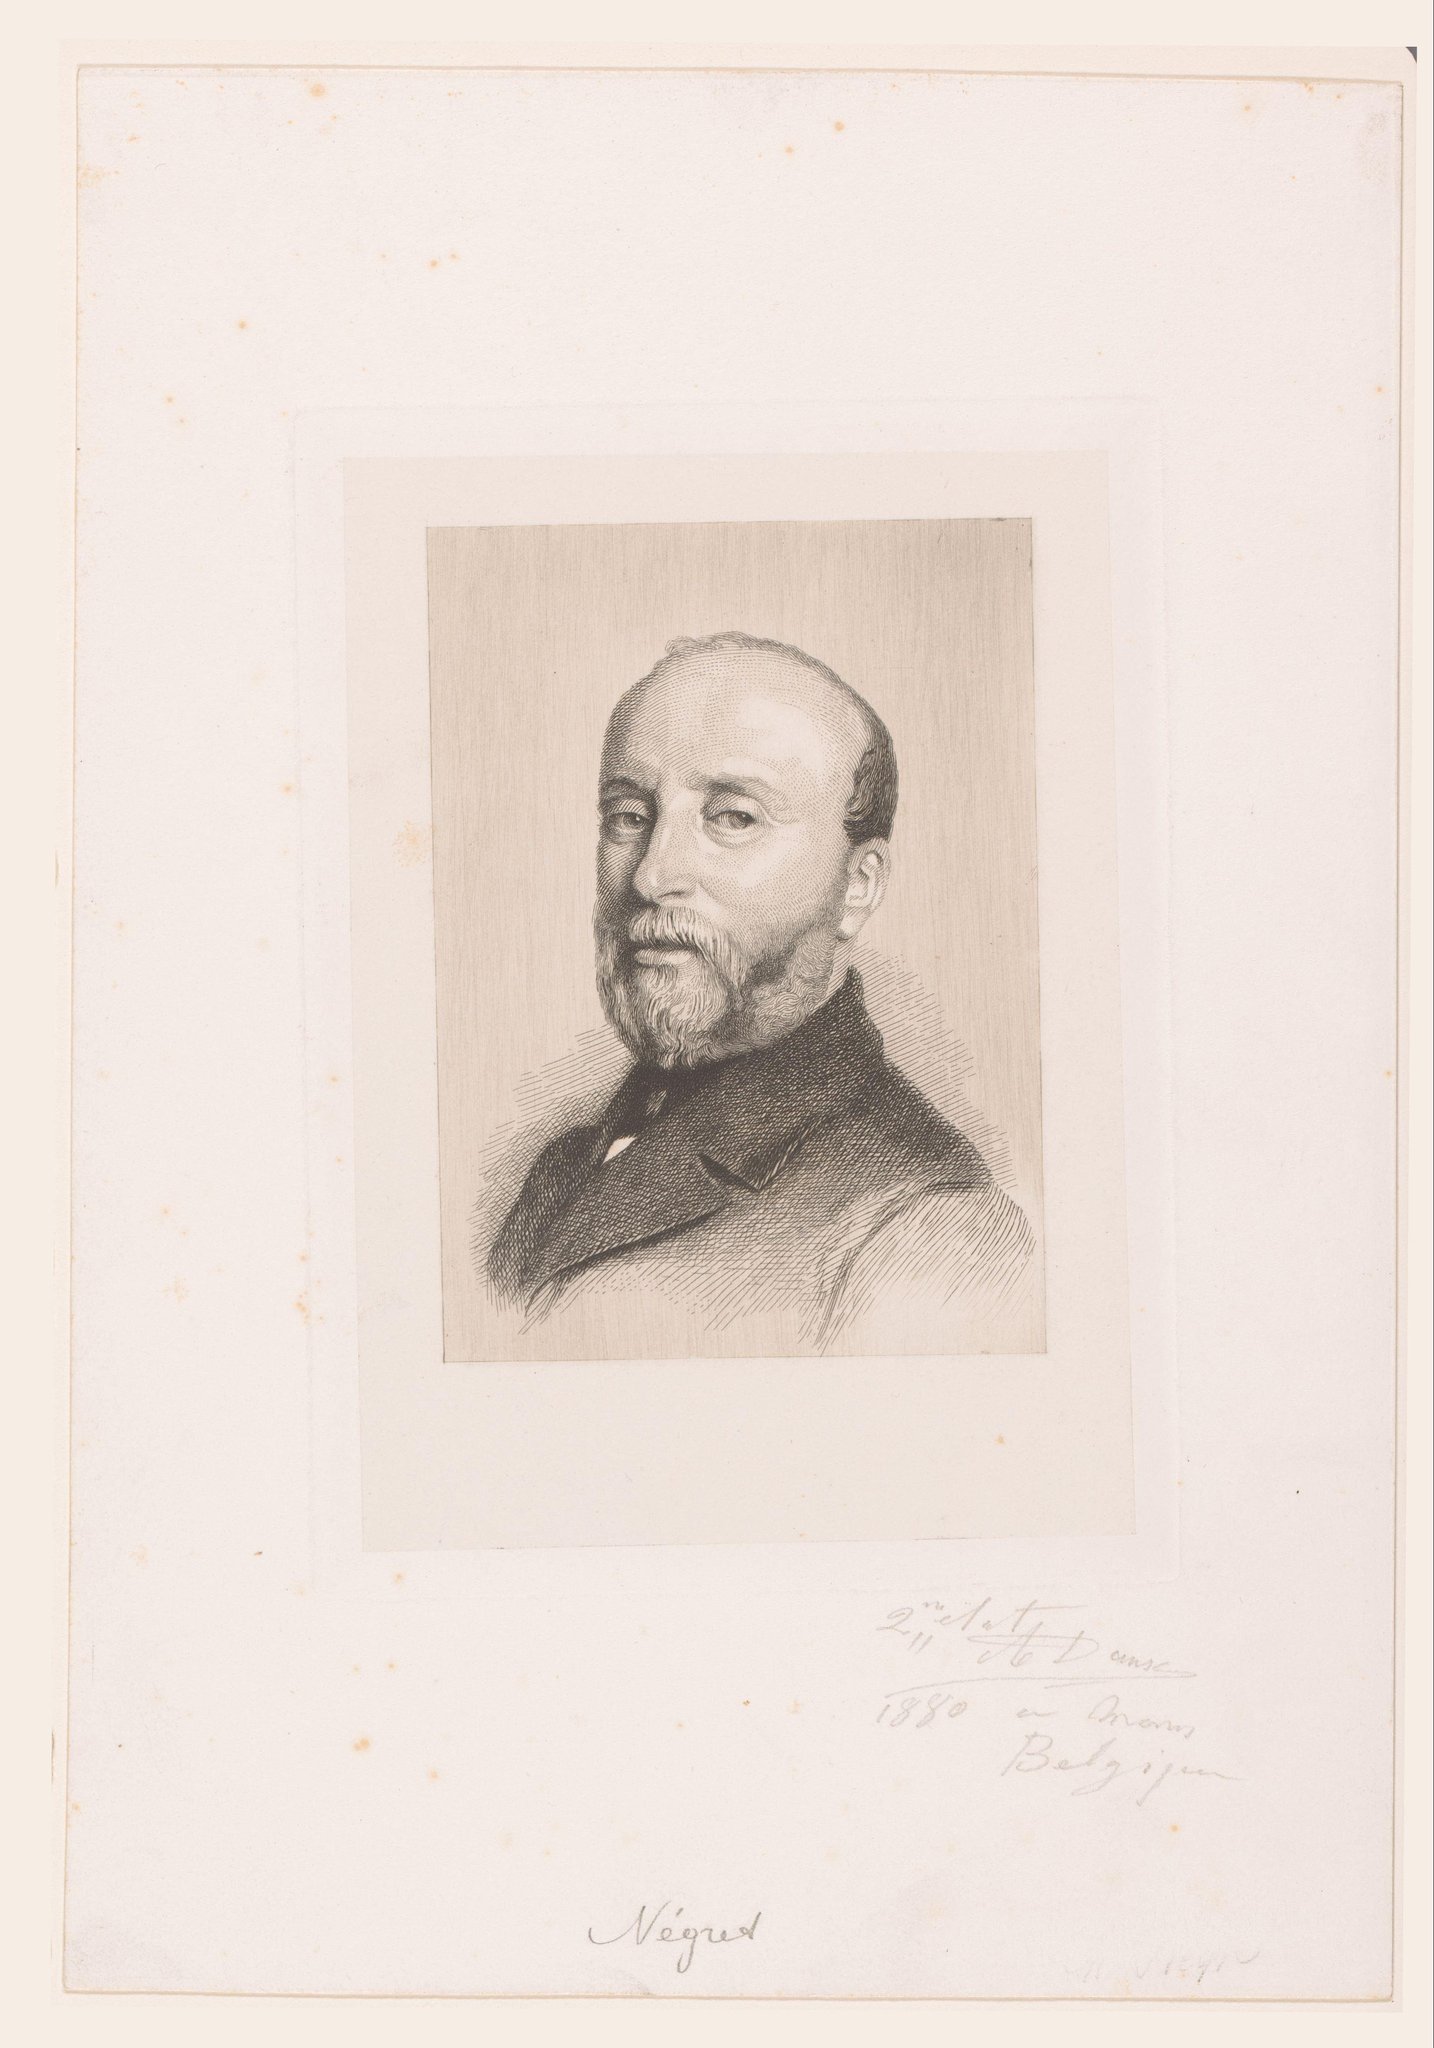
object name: print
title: Portret van een onbekende man genaamd Négret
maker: auguste danse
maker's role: print maker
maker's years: 1829-1929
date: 1880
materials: paper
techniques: etching, intaglio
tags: anonymous historical person portrayed alone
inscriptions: annotation: ‘2m état’, collector's mark: Lugt 2228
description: De naam Négret komt voor als handgeschreven annotatie op recto en verso.